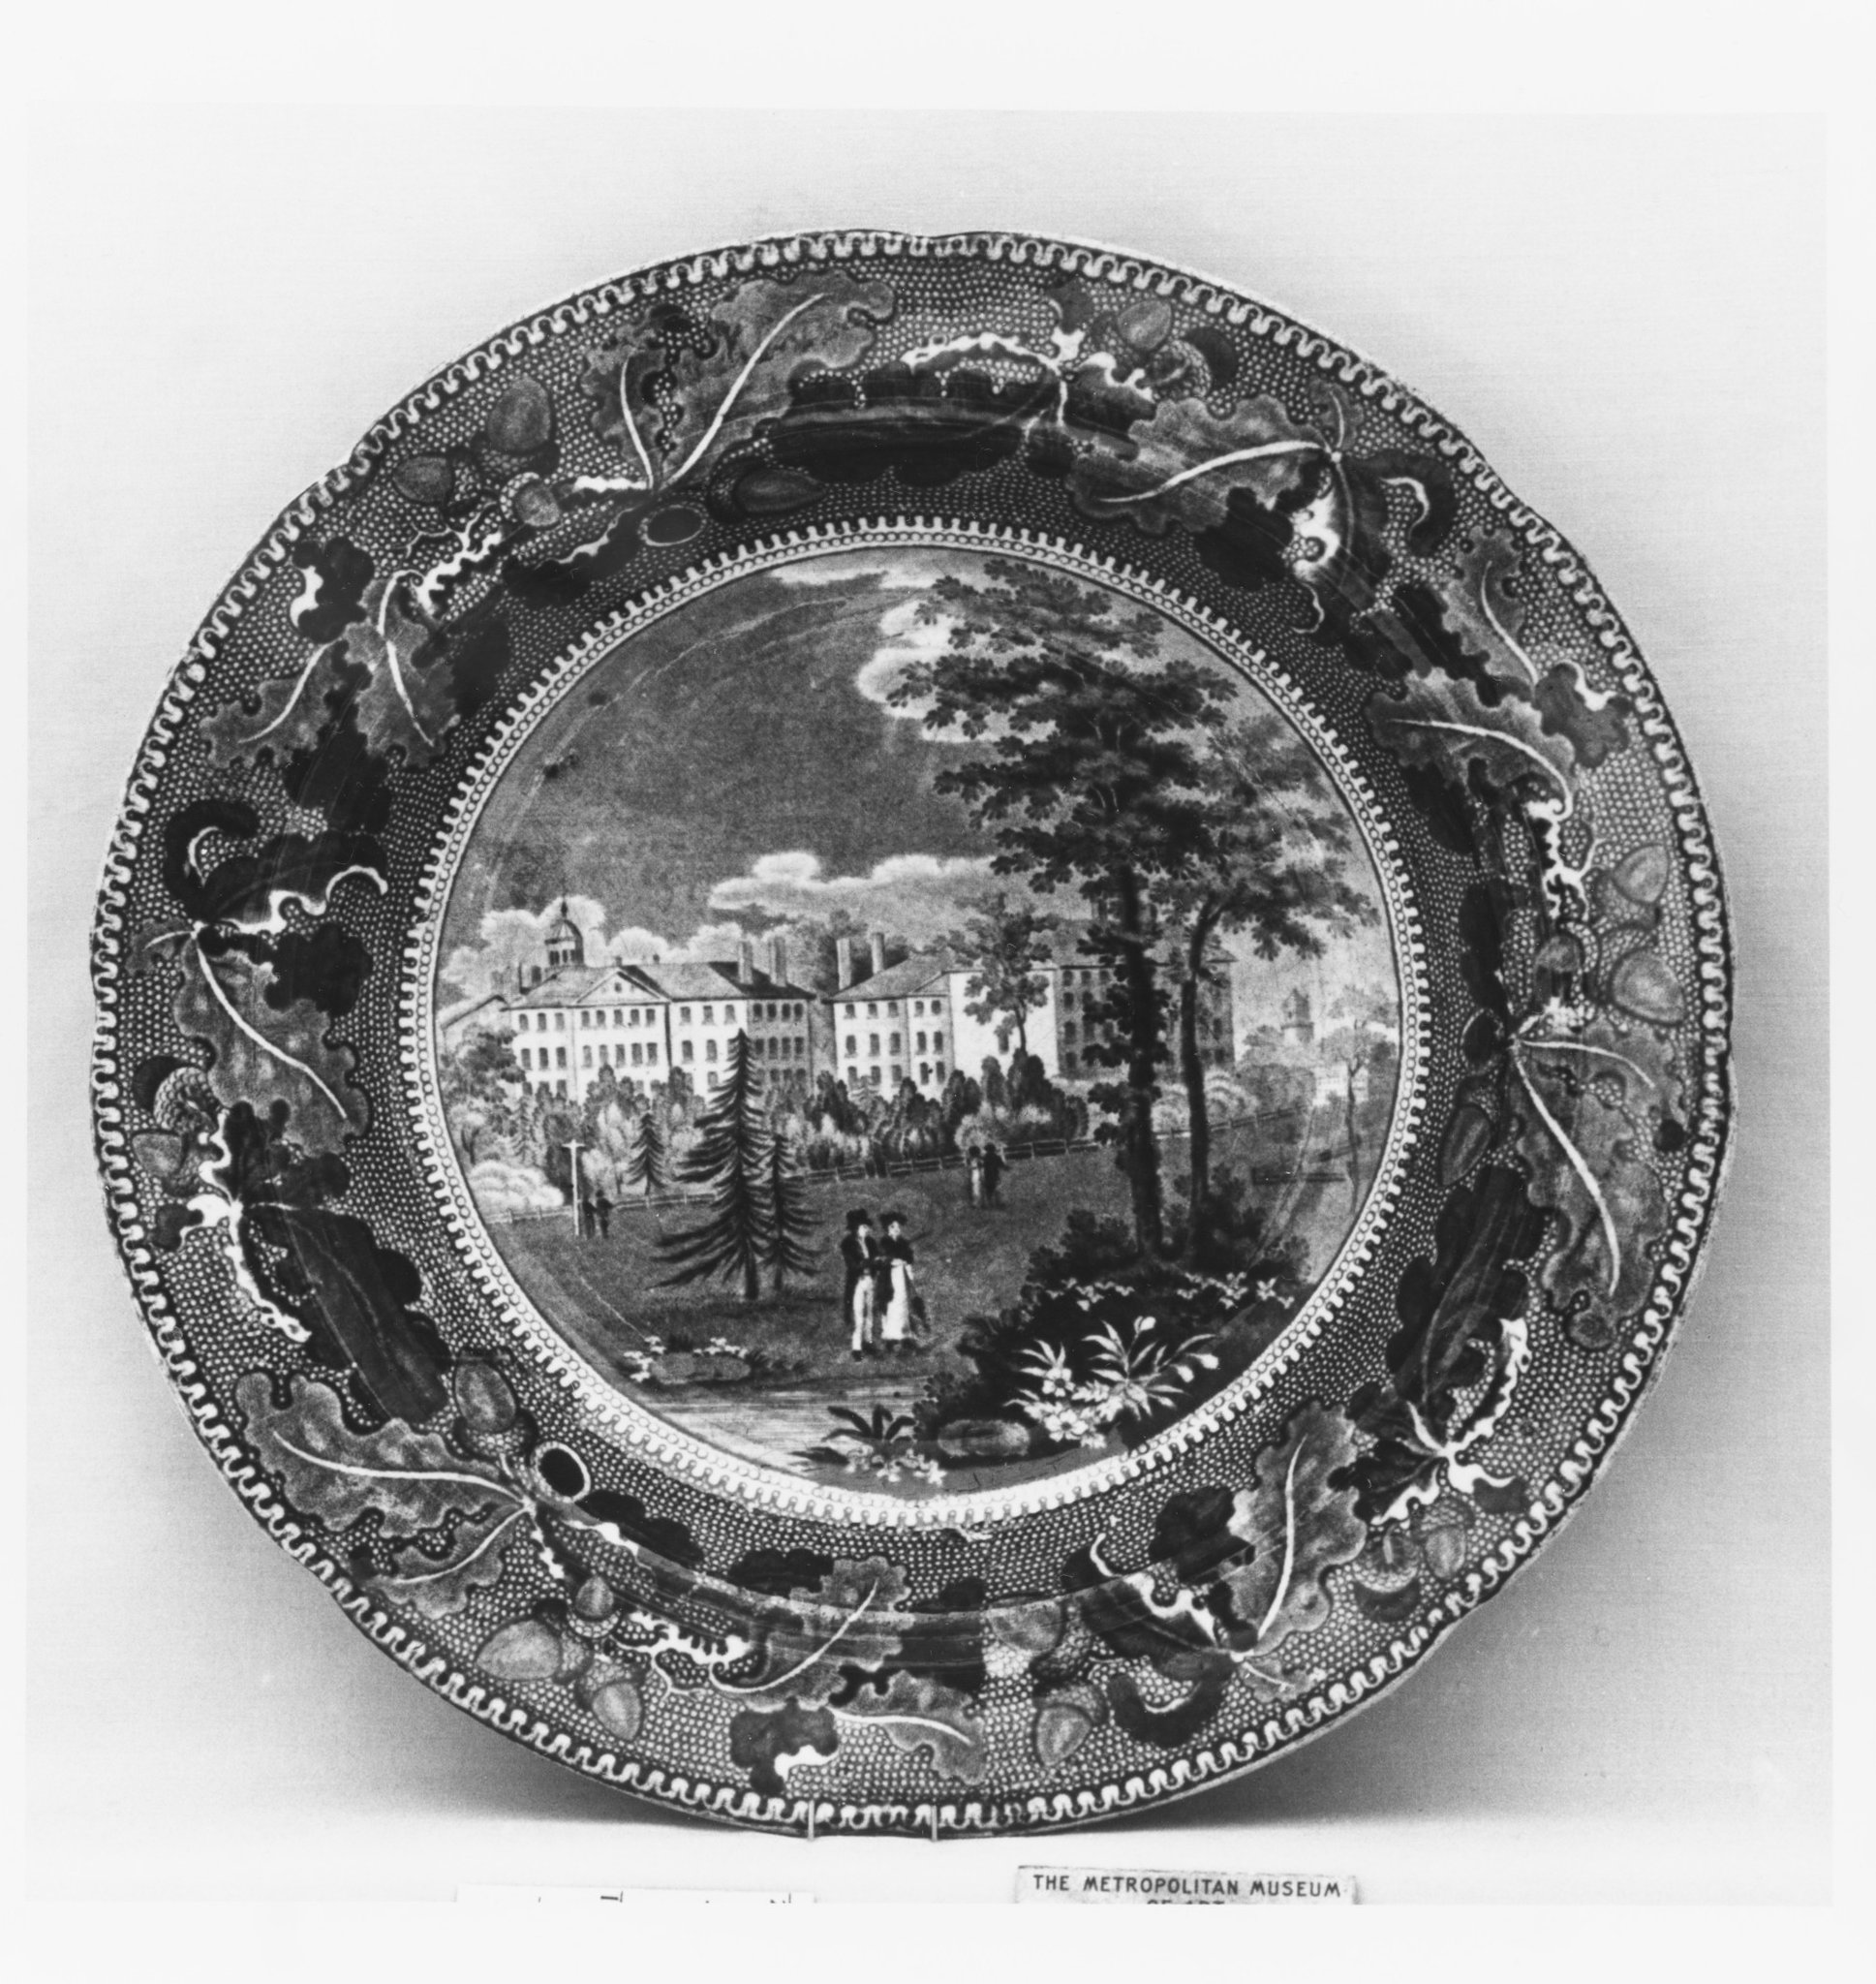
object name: plate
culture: british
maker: ralph stevenson & williams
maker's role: maker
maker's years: 1822-1827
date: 1825-1827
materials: earthenware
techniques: transfer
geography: england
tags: buildings,trees